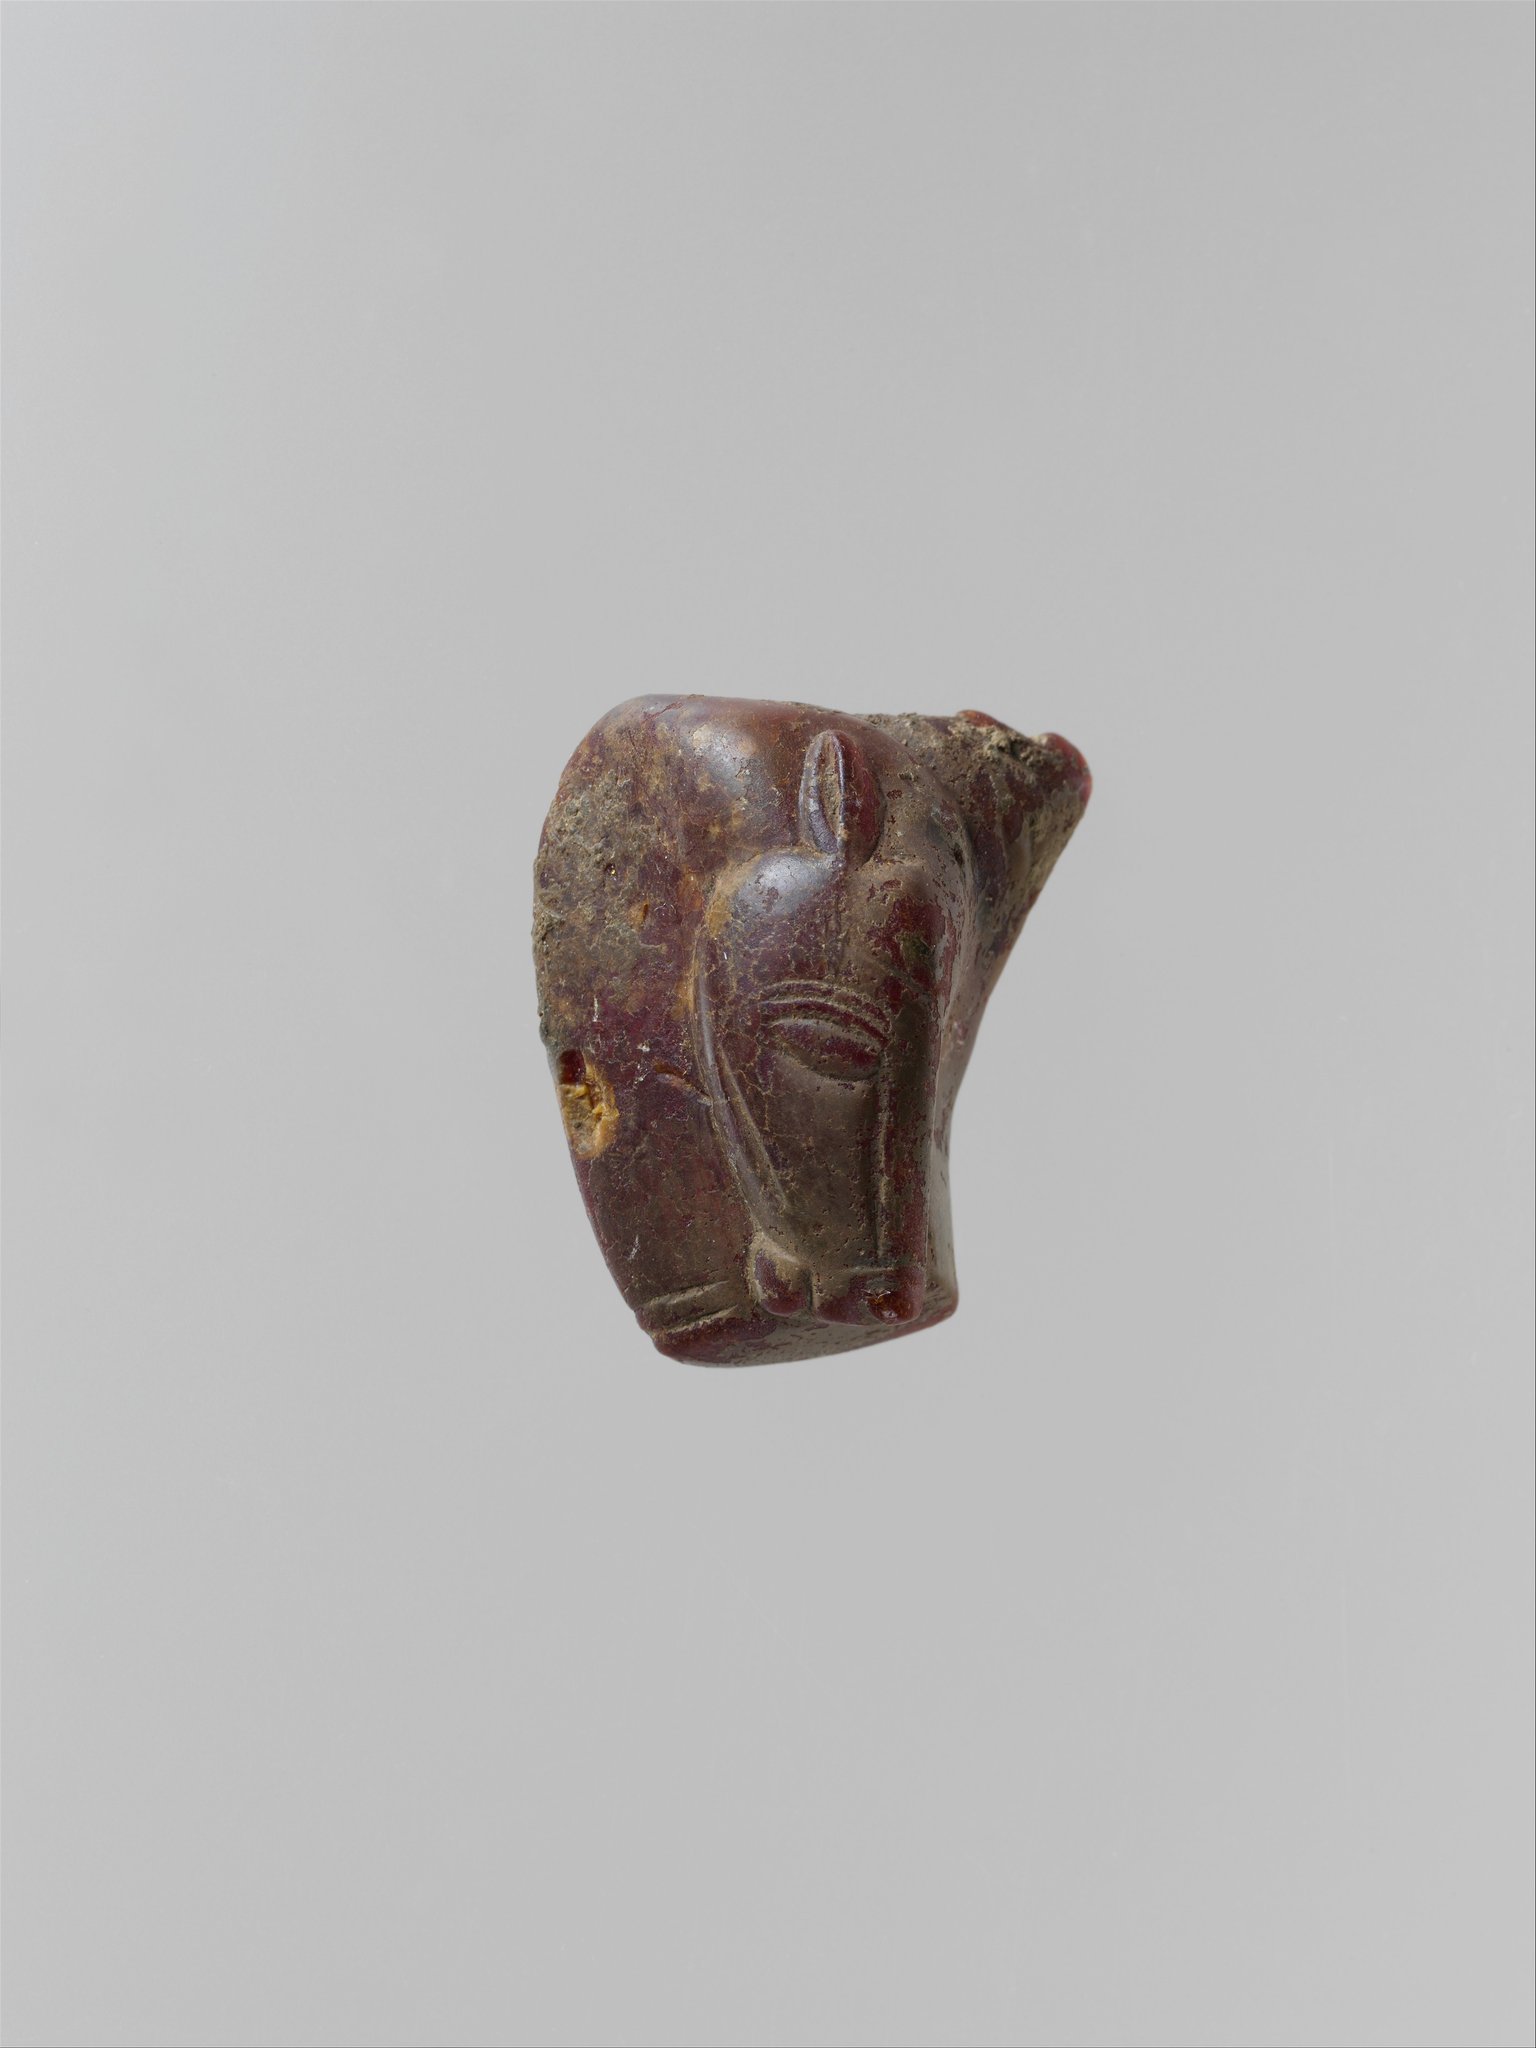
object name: horse head, fragment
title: Pendant: head and neck of a horse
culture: italic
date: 500-301 BCE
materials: amber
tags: horses